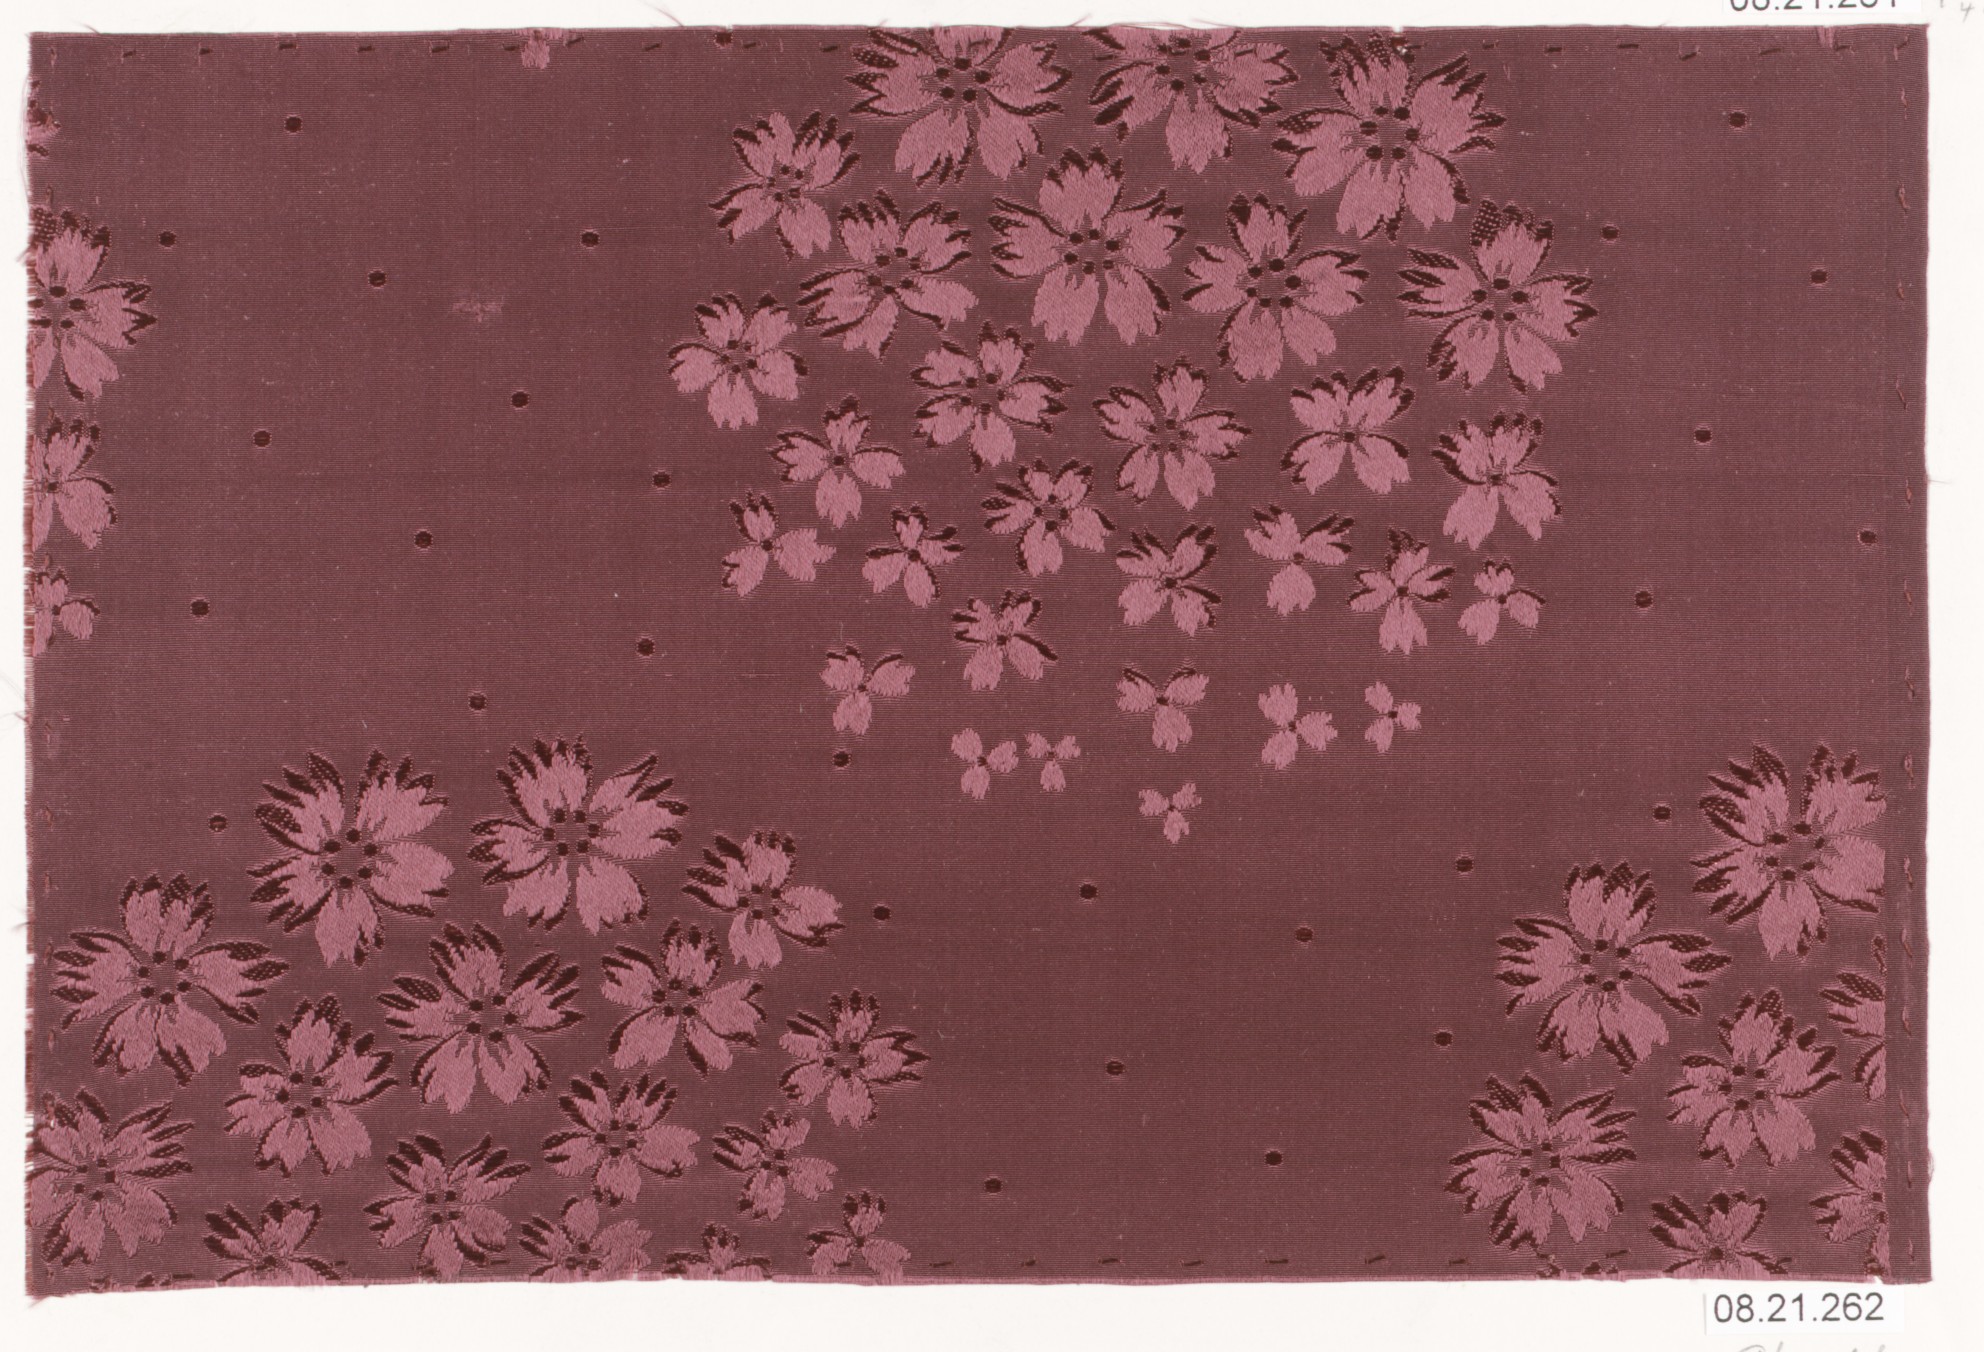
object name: textile sample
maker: Anonymous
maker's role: designer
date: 1900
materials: silk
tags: flowers